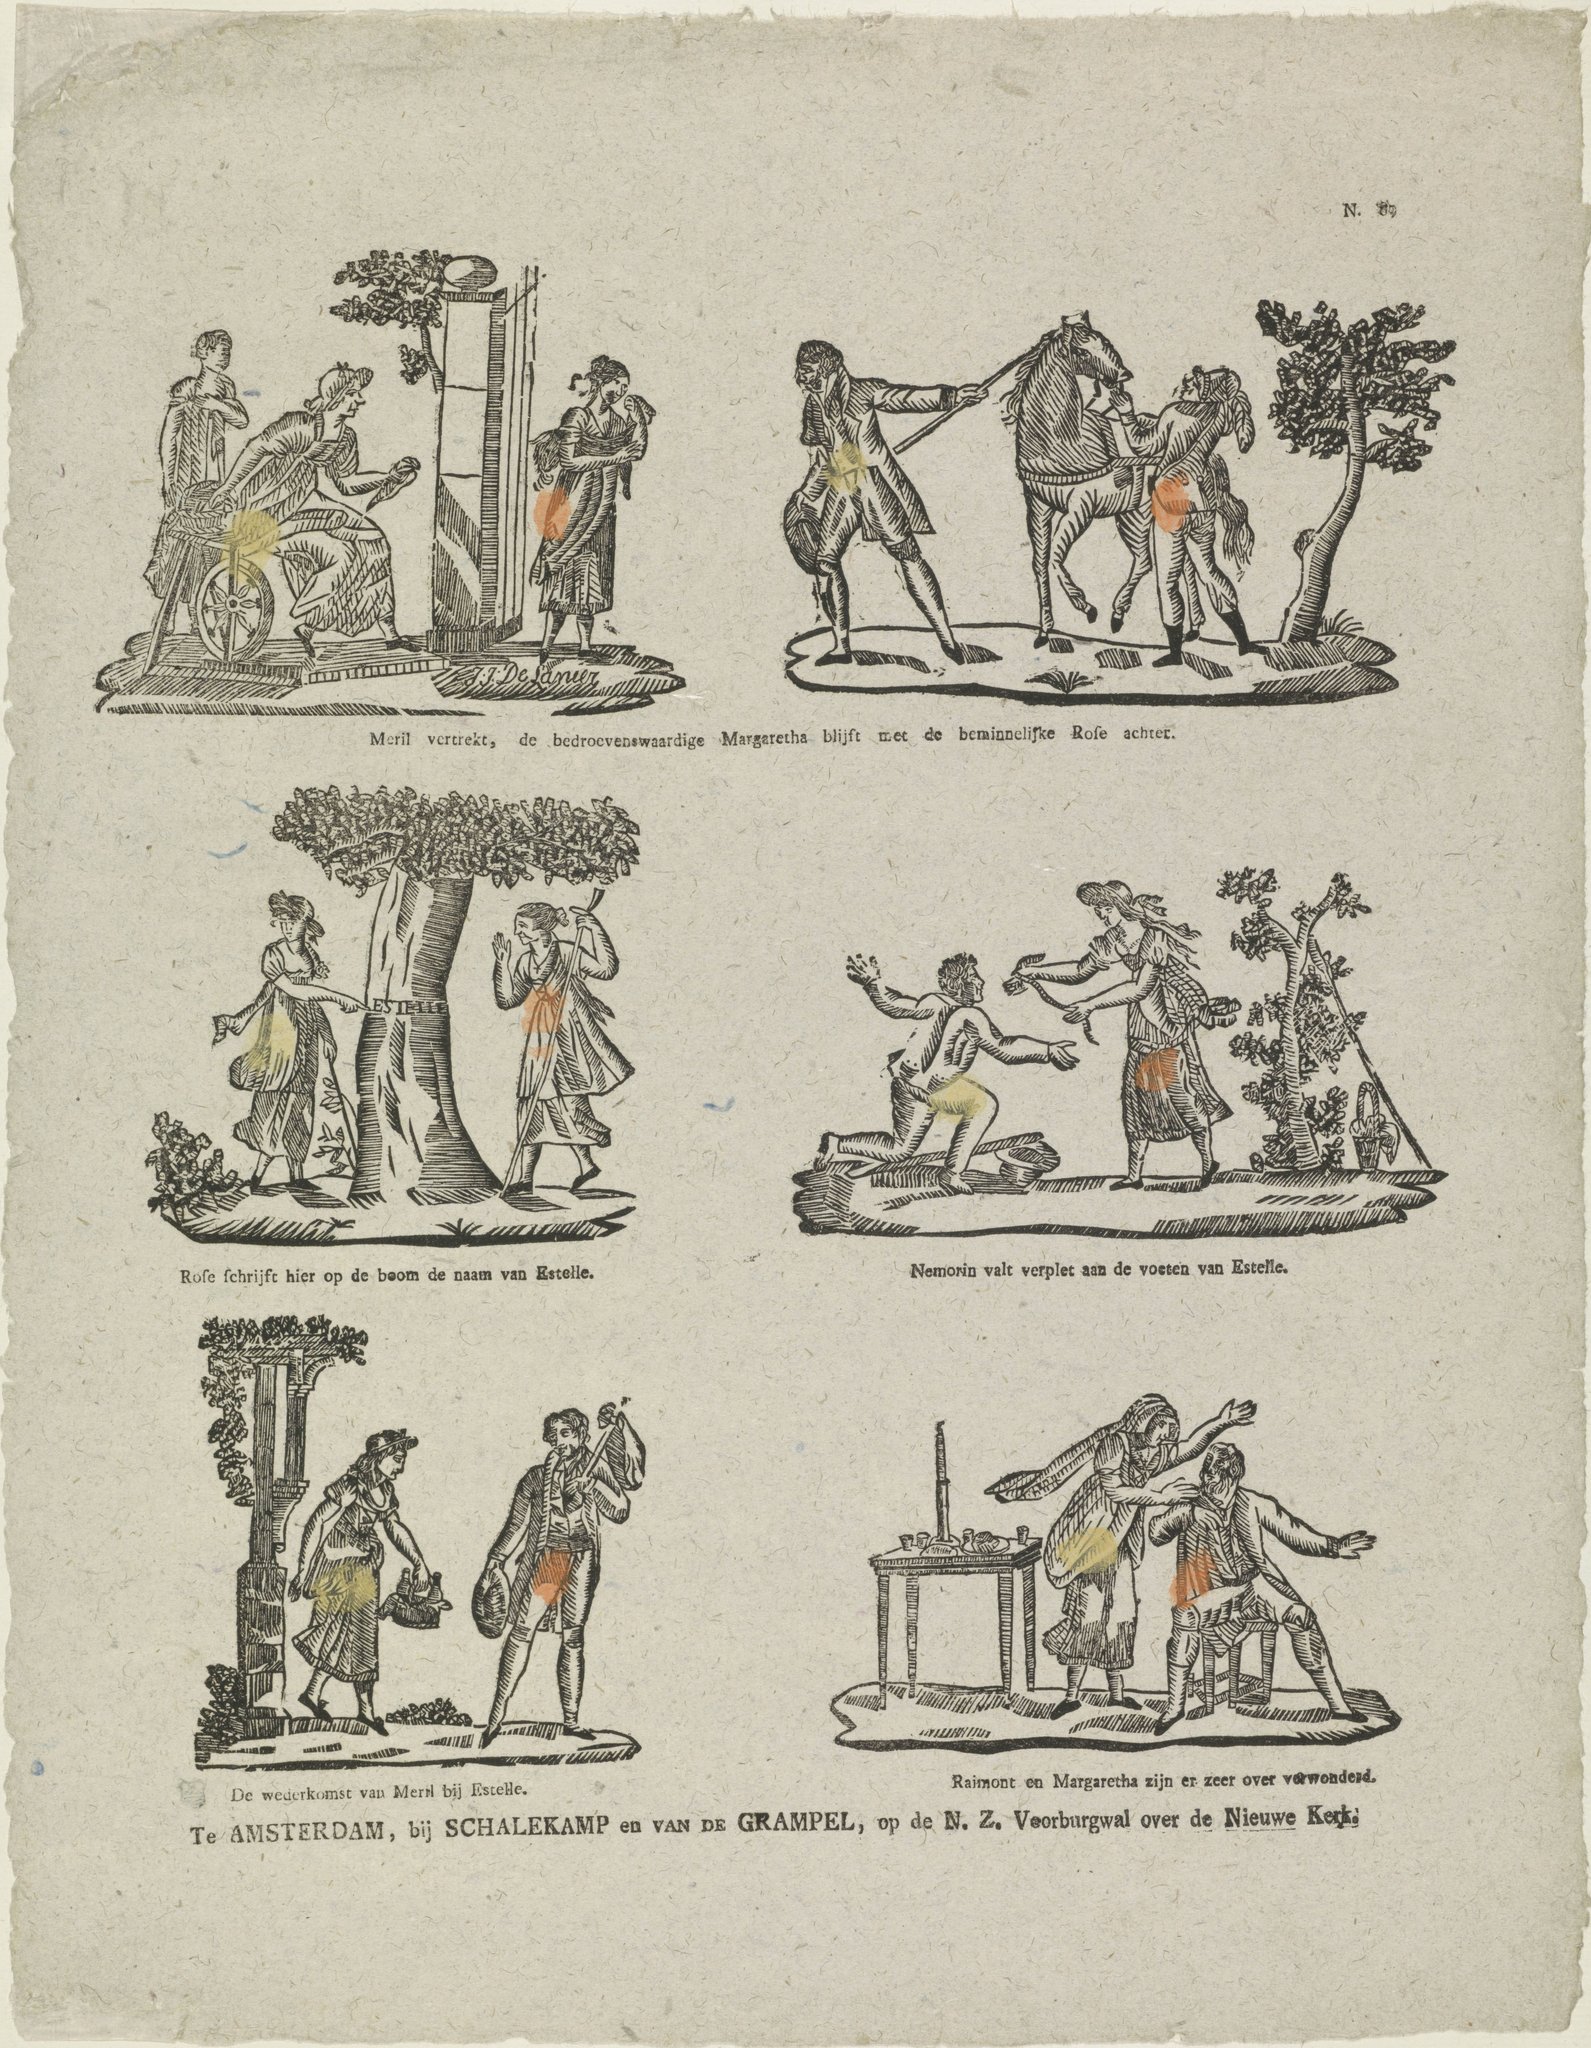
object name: print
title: Némorin en Estelle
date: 1822-1849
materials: paper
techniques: colour, letterpress printing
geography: deventer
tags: tales and fairy tales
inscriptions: collector's mark: Lugt 2760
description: Blad met 6 voorstellingen uit het verhaal van Estelle en Némorin, naar de roman van Jean-Pierre de Claris de Florian uit 1787. Onder elke afbeelding een onderschrift. Genummerd rechtsboven: N. 89.